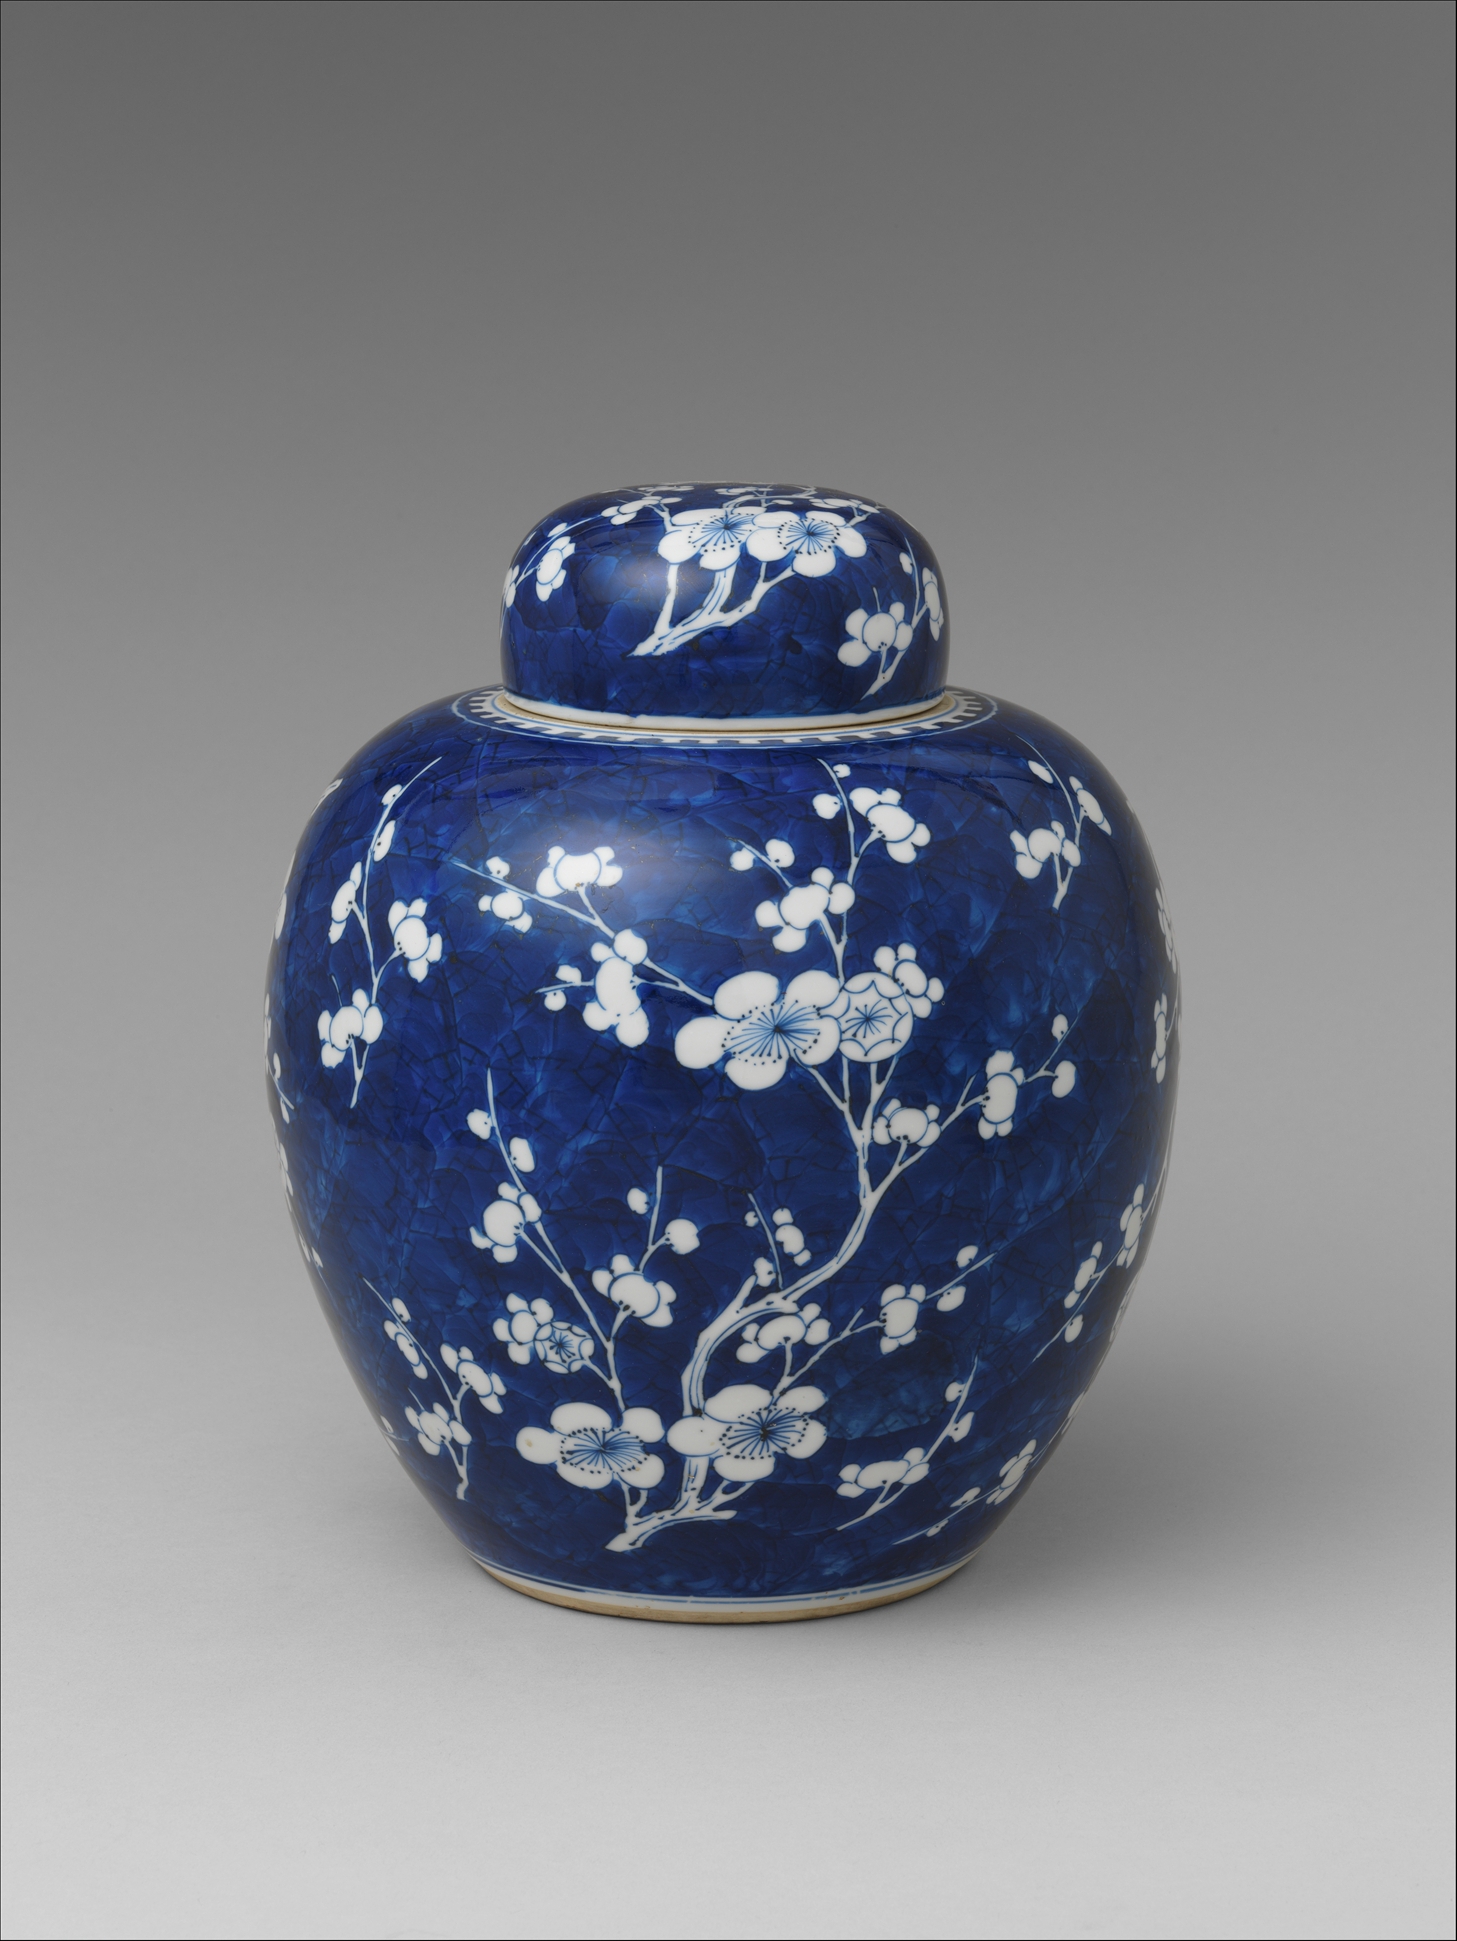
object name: covered jar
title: Covered jar decorated with blossoming plum and cracked ice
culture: chinese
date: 1667-1733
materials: cobalt, glaze, porcelain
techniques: painting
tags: flowers